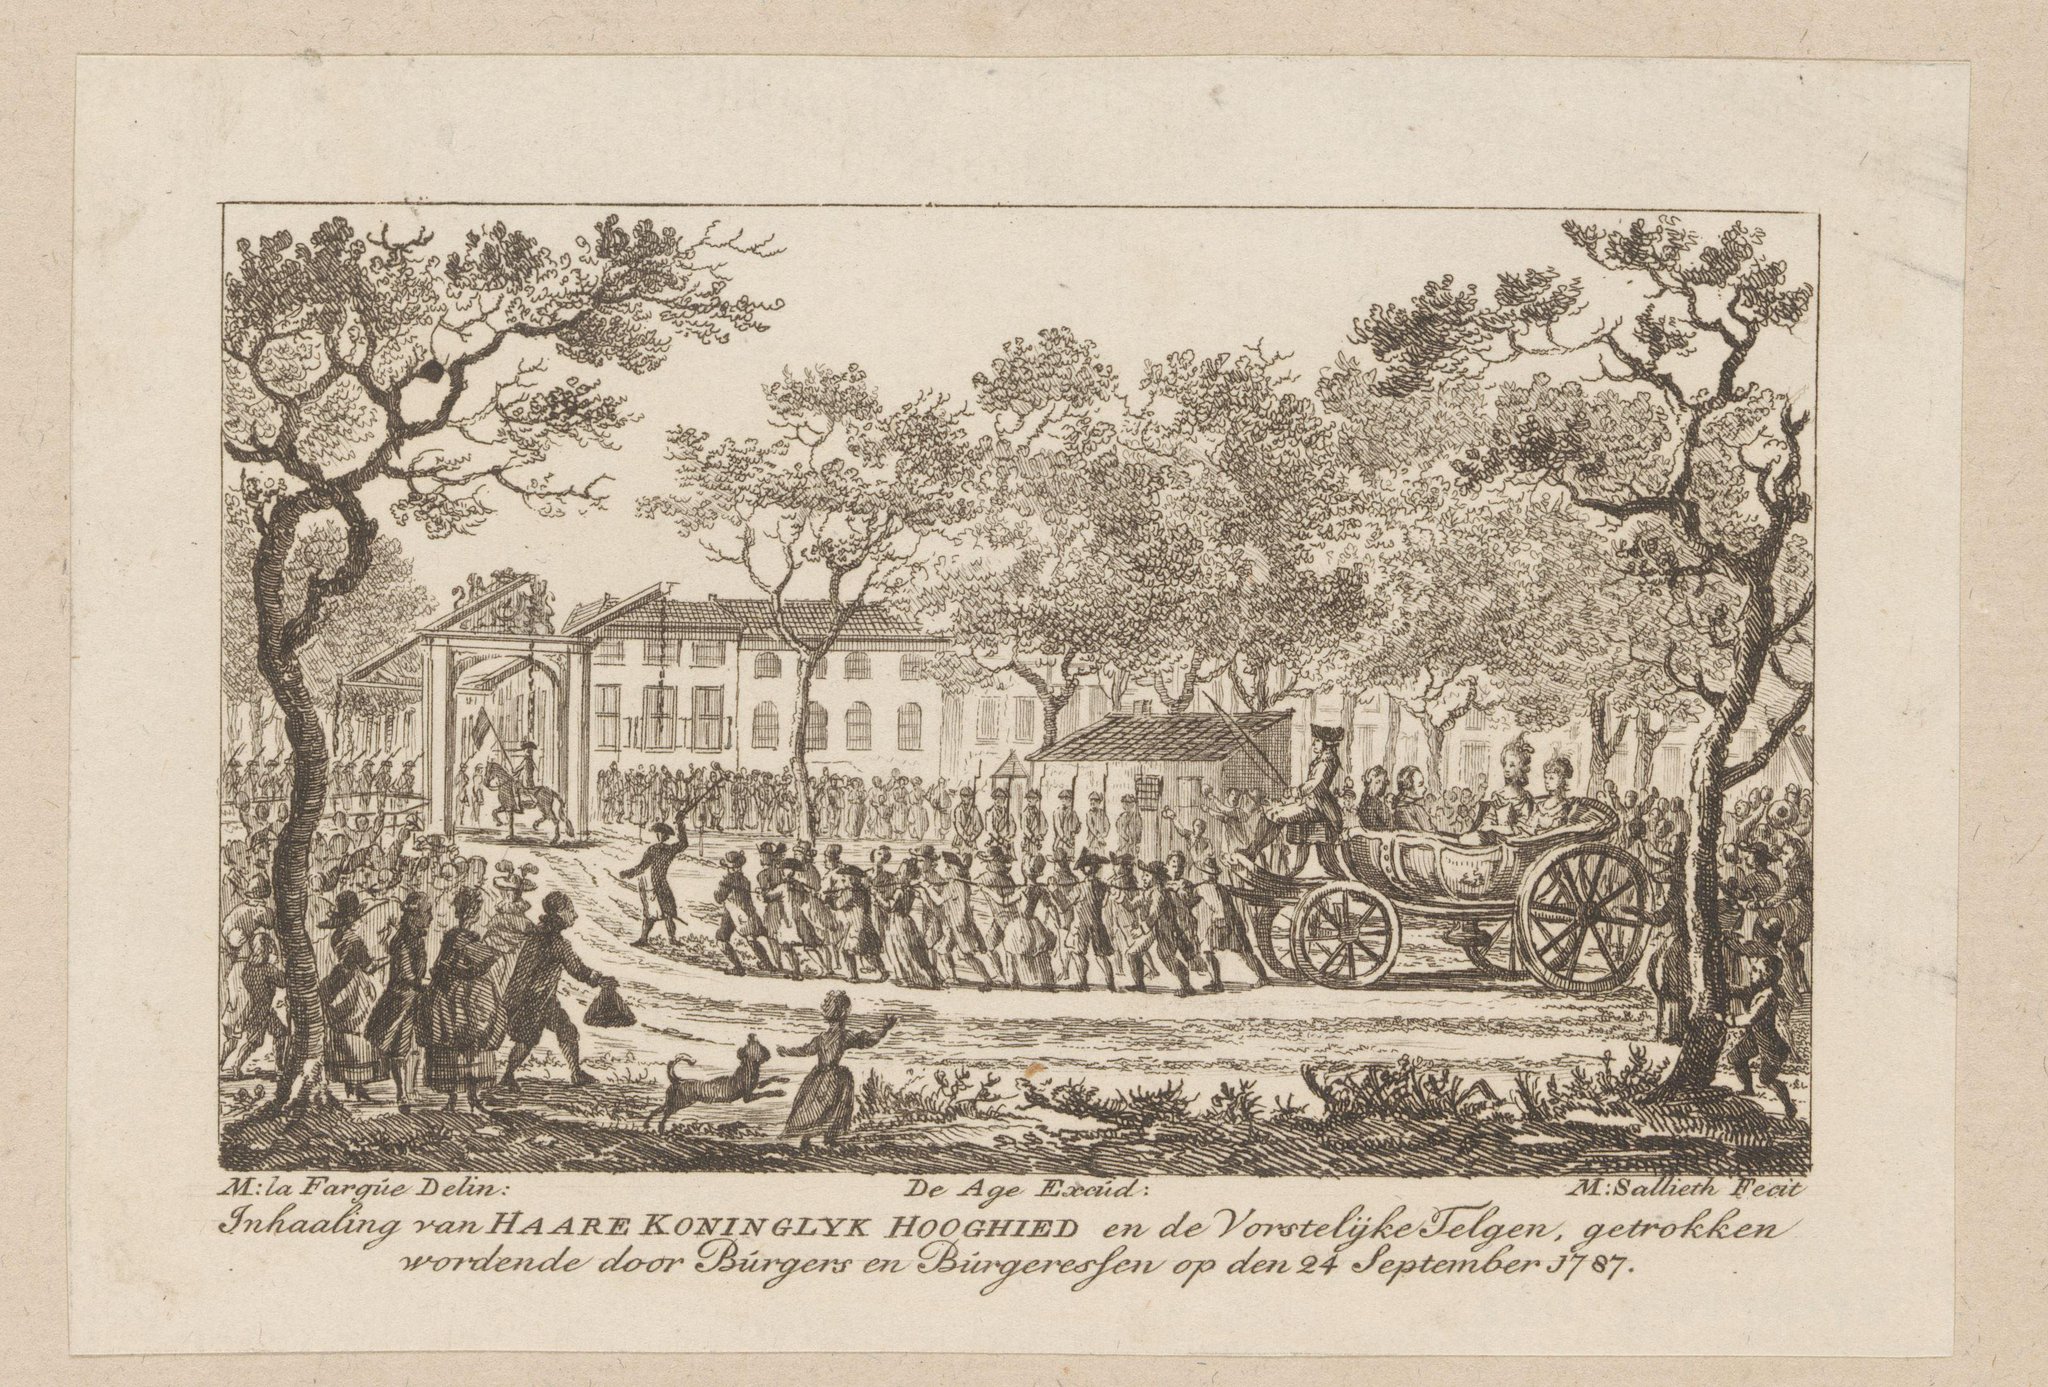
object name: print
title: Wilhelmina van Pruisen en haar kinderen rijden Den Haag binnen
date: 1787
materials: paper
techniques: etching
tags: the hague, berlin, william i of the netherlands, draughtsman, wilhelmina of prussia (princess of orange), louise (prinses van oranje-nassau), willem george frederik (prins van oranje-nassau), public festivities at other royal events, not meant or mentioned above, human being(s) drawing or pushing a vehicle not usually propelled by manpower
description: Wilhelmina van Pruisen en haar drie kinderen rijden de stad binnen in een koets die getrokken wordt door een groep burgers van Den Haag. De stoet wordt voorafgegaan door een groep militairen. Het volk staat langs de weg en verwelkomt de vorstin.